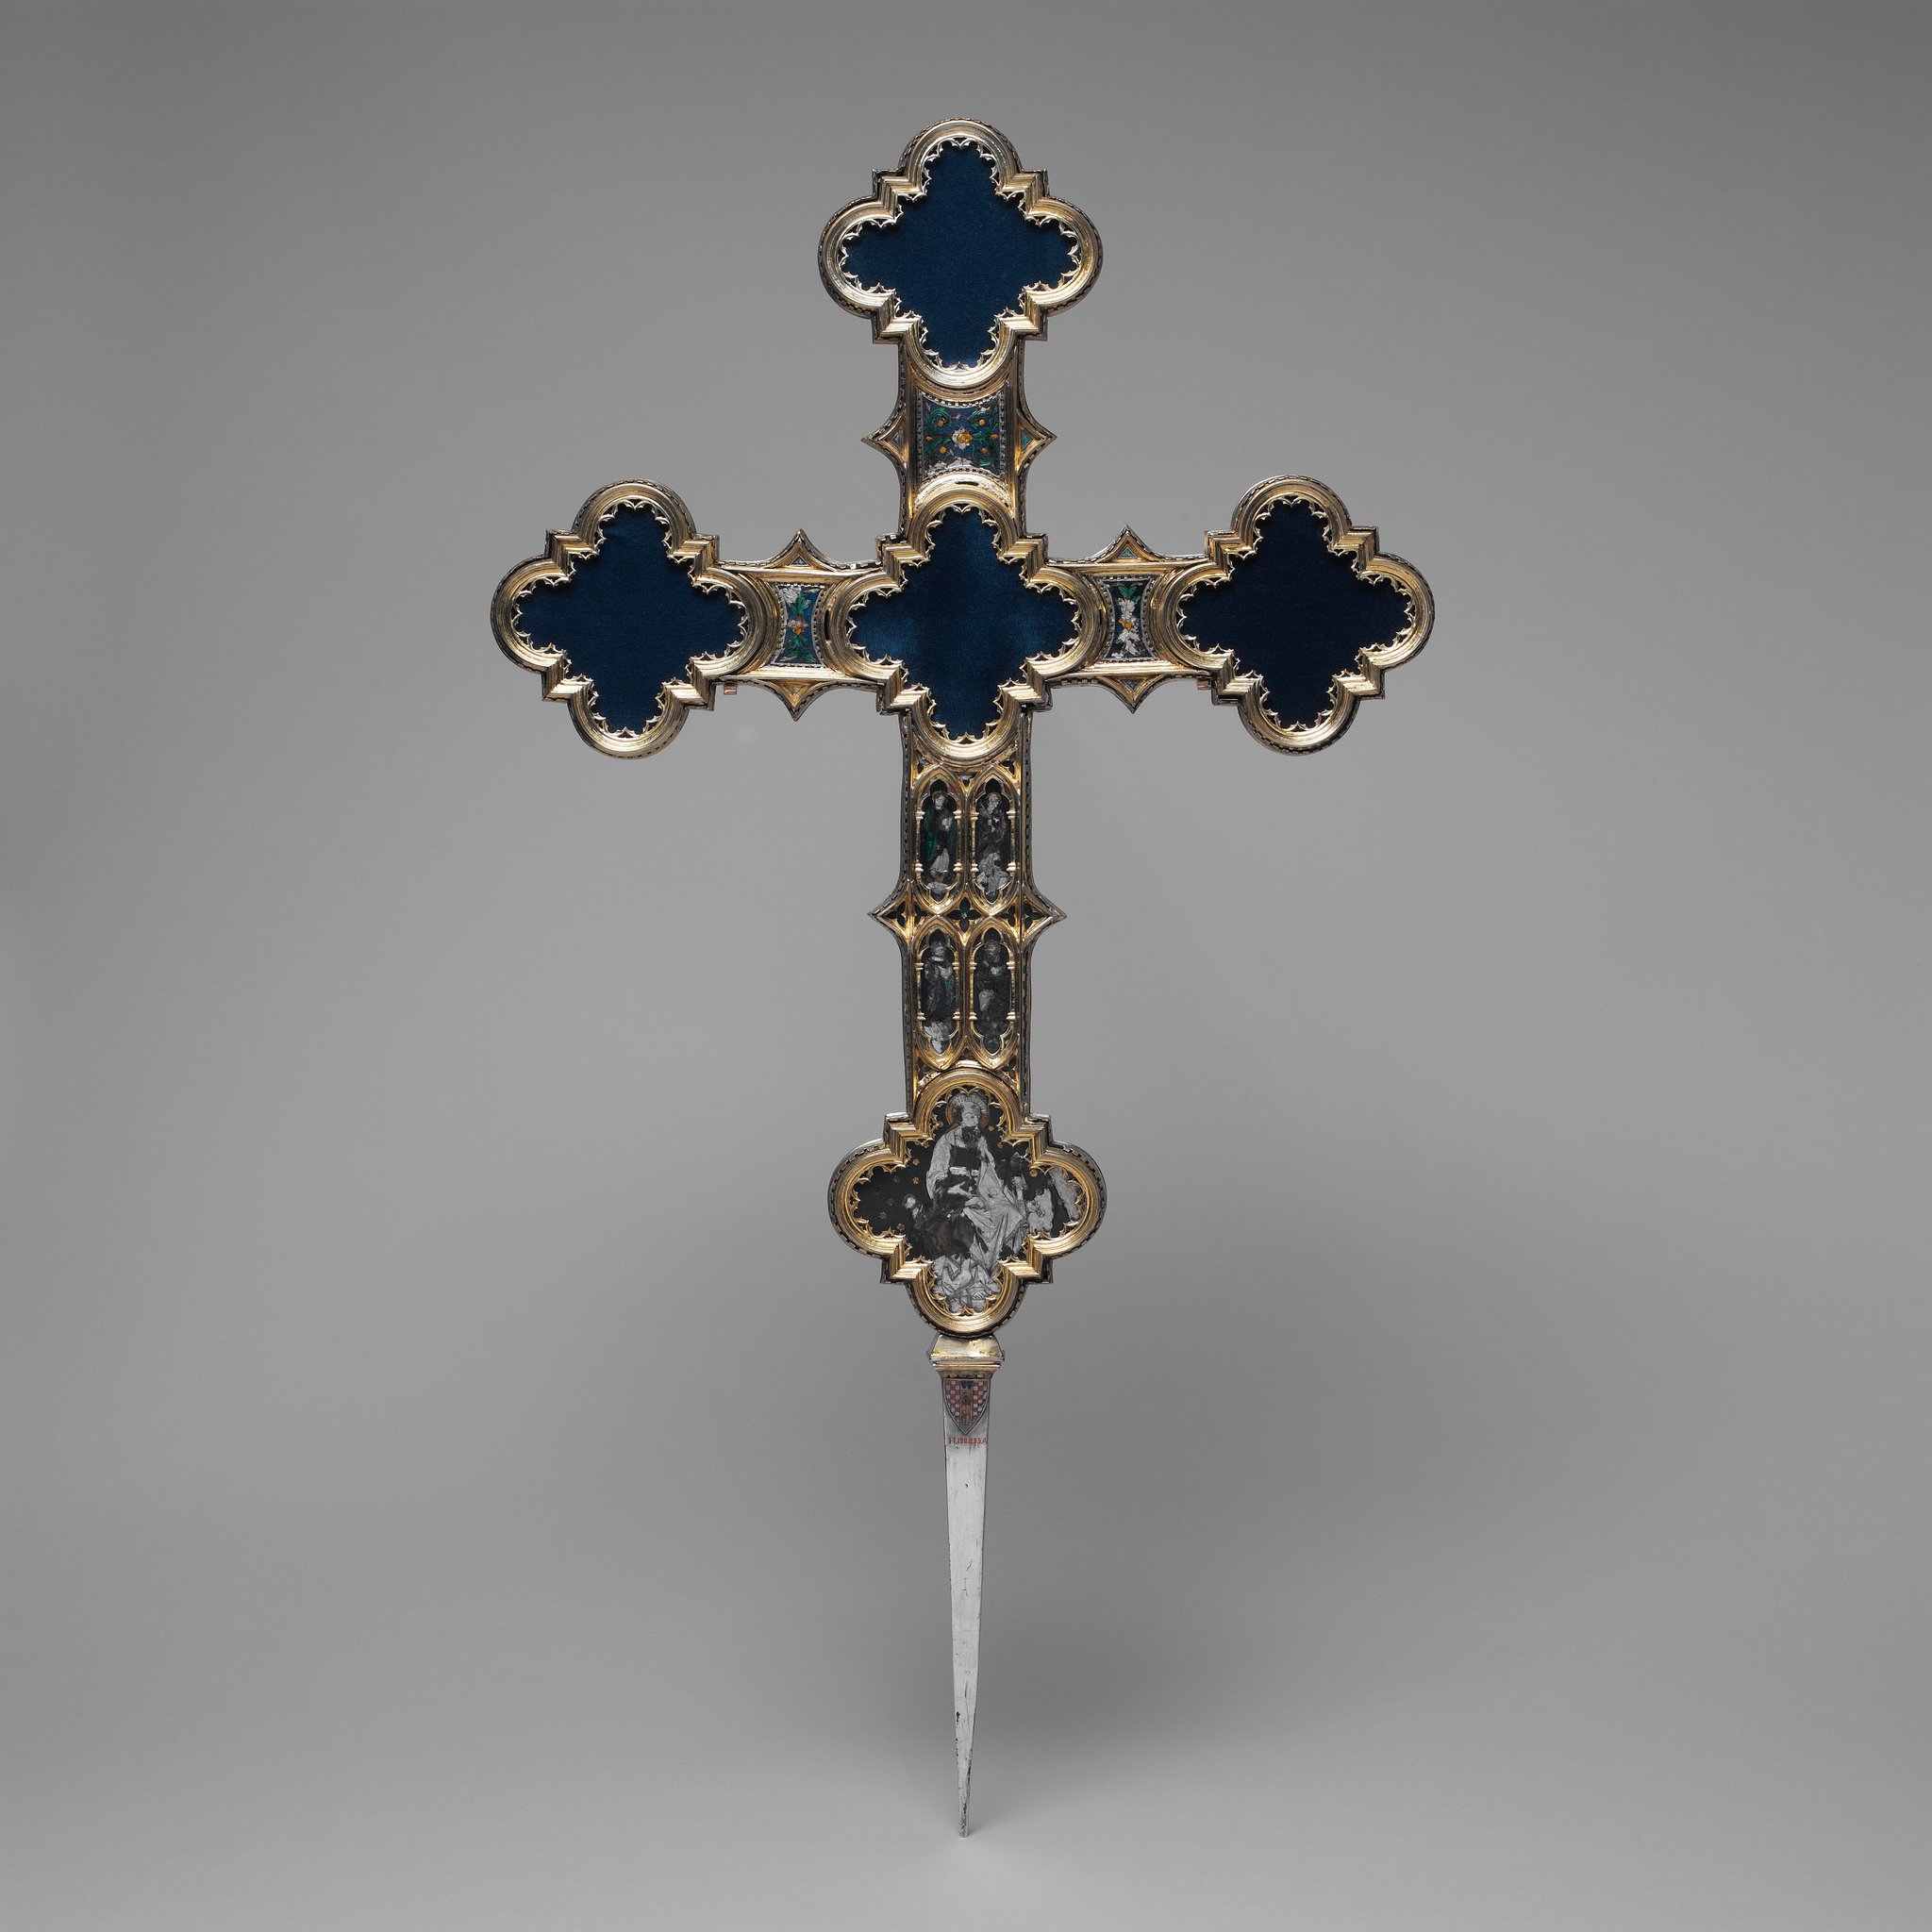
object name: processional cross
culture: italian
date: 1401-1500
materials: enamel, gilt, glass, silver, velvet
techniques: enamel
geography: italy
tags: mary magdalene,saints,coat of arms